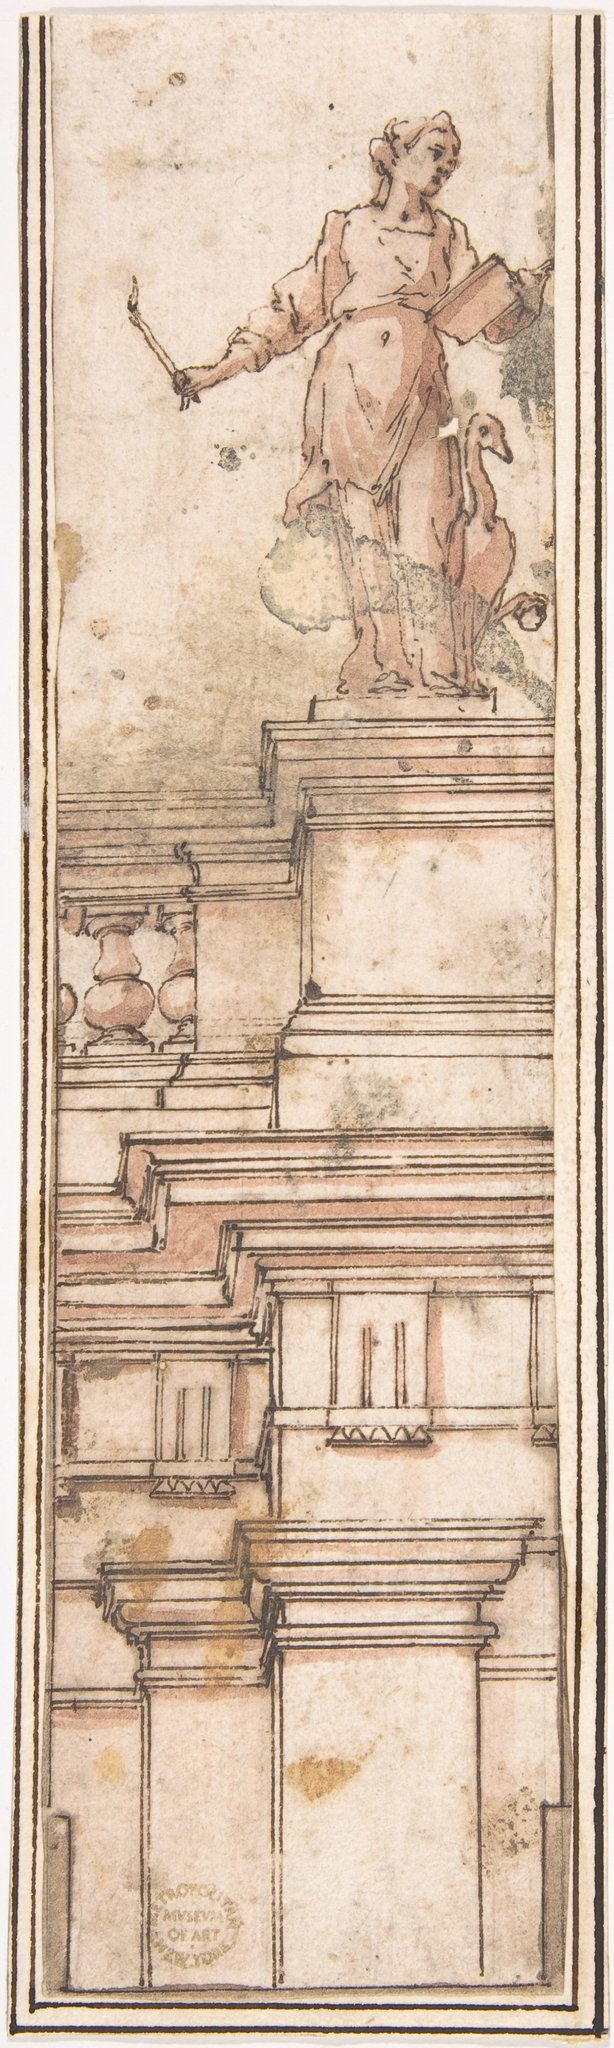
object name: drawing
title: Façade (for Stage Setting)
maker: anonymous, italian, 16th century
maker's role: artist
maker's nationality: italian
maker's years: 1550-1600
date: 1501-1600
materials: ink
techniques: pen, wash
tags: architecture